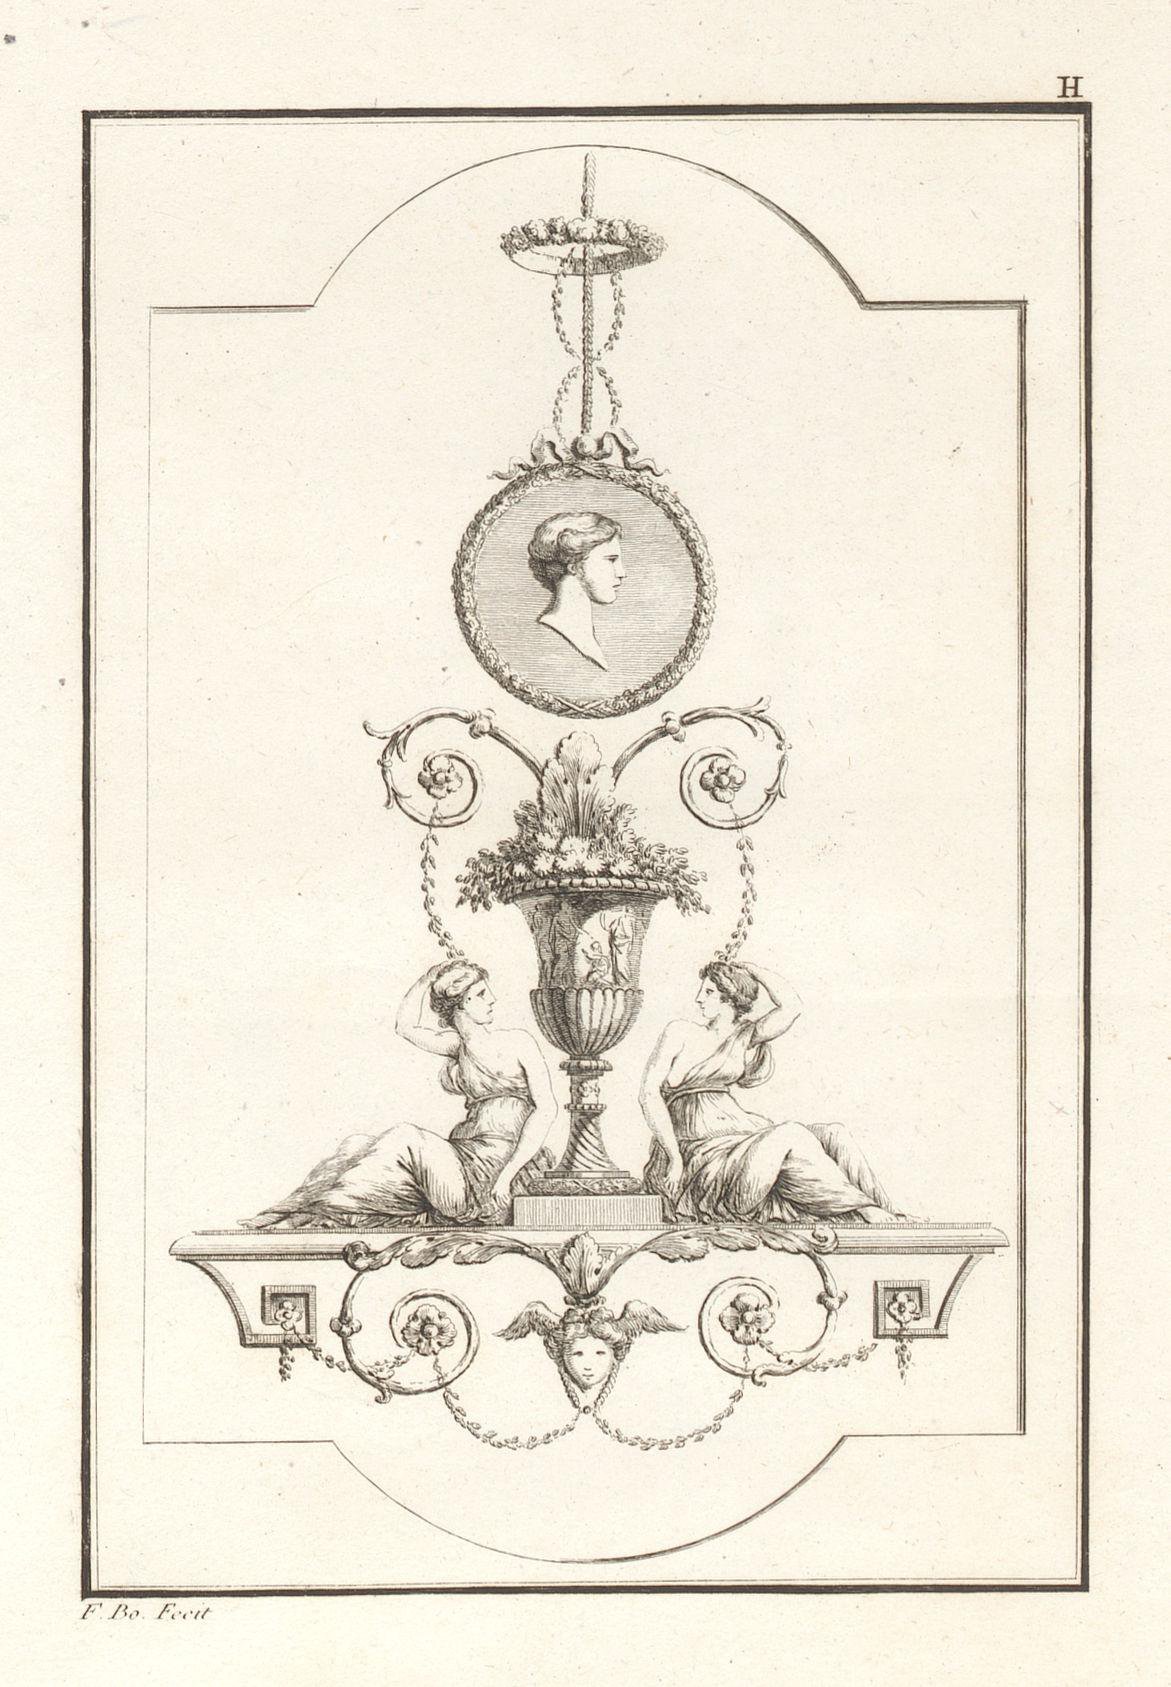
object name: print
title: VIIIe. cahier d'arabesques composés et gravés par François Boucher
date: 1802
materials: paper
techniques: etching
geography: paris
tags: adult woman, ornament ~ arabesque, anonymous historical person portrayed alone, vase ~ ornament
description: Doordat dit album bestaat uit meerdere, deels eerder uitgegeven prentreeksen, is de datering niet consequent. Het geheel is op de titelpagina gedateerd op 1802. Deze reeks is niet los gedateerd. De serietitel voor het gehele werk is "Recueil d'arabesques, contenant les loges du Vatican". De andere serietitel is de titel van de specifieke reeks binnen het geheel.